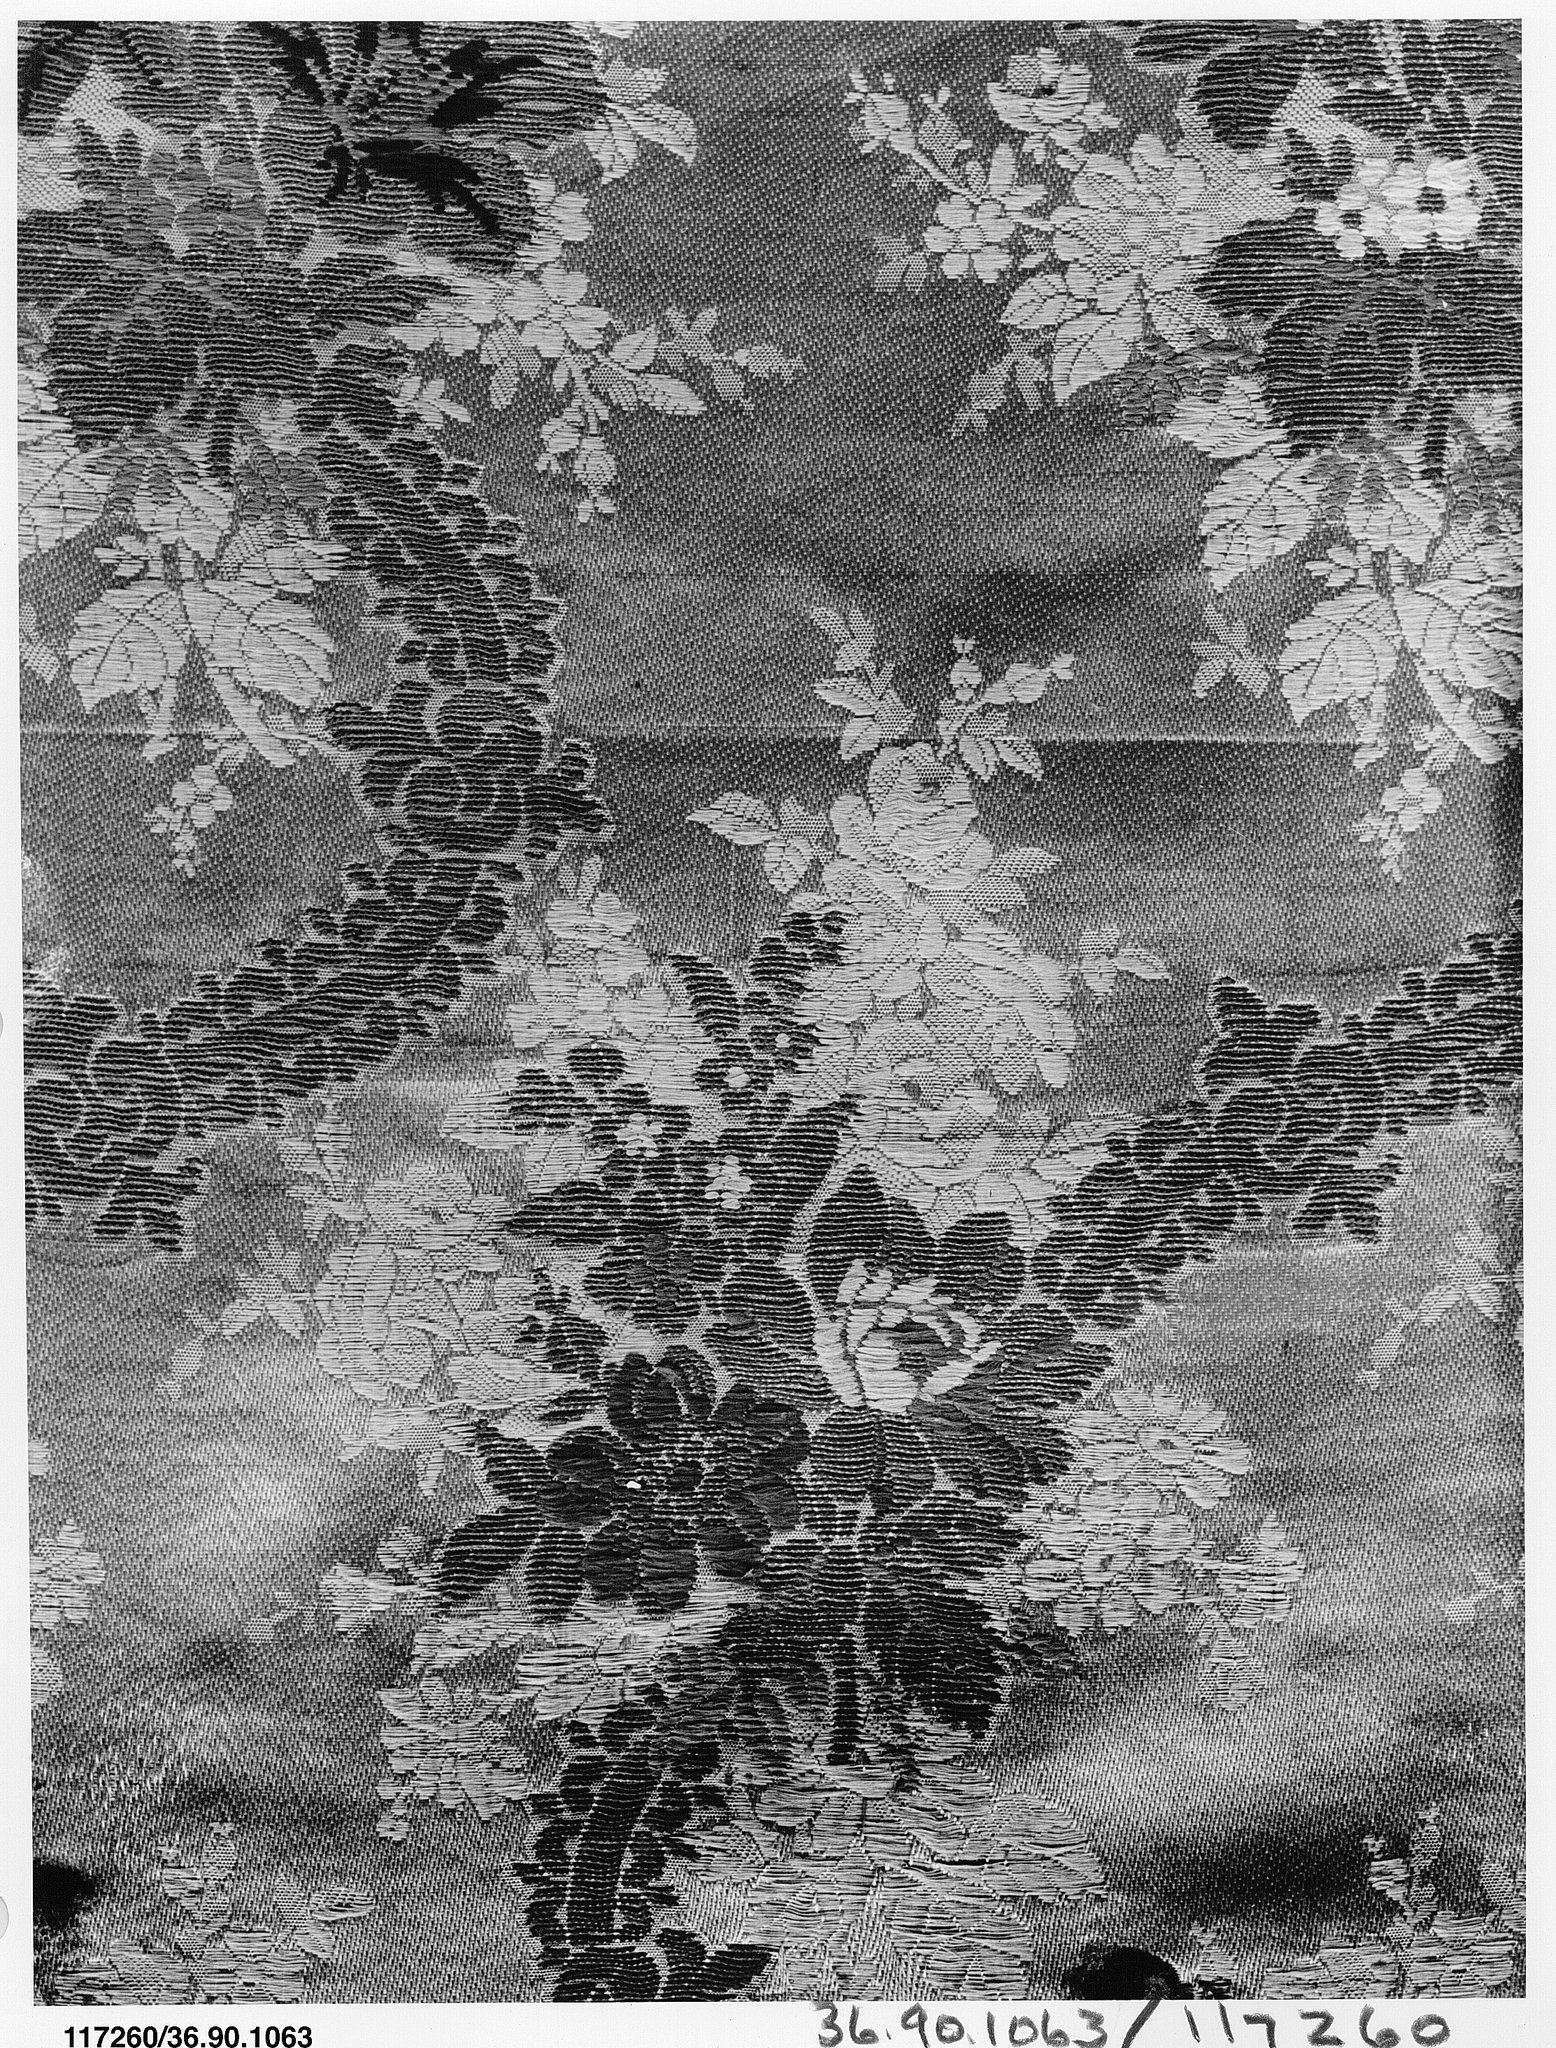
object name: piece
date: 1801-1900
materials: metal thread, silk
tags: flowers,leaves